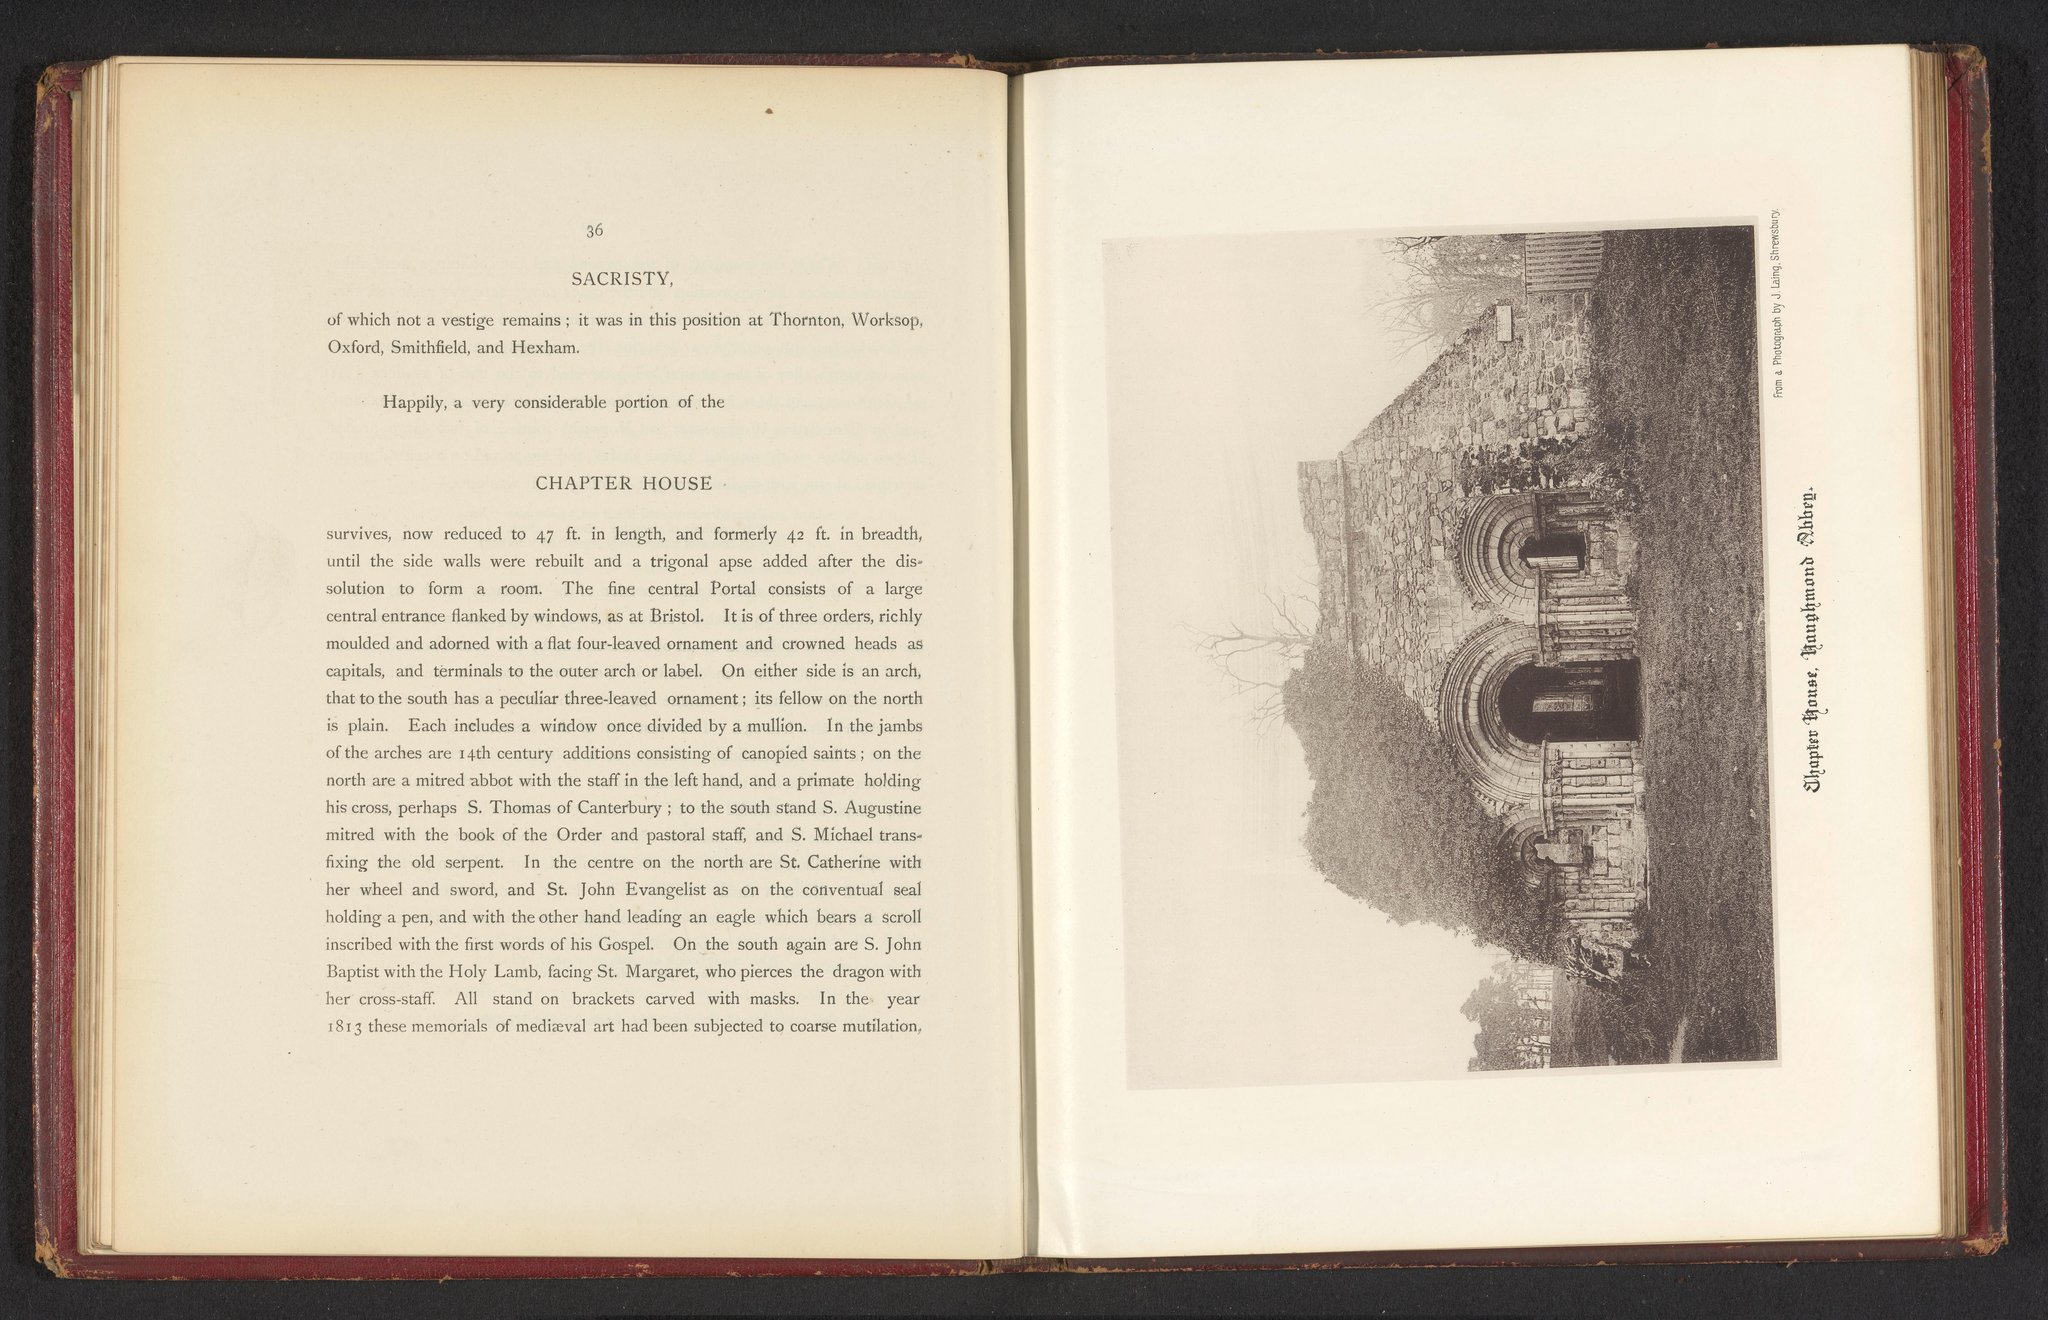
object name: photomechanical print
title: Chapter House, Haughmond Abbey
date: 1867-1877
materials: paper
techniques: photograph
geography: haughmond abbey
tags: ruin of church, monastery, etc.